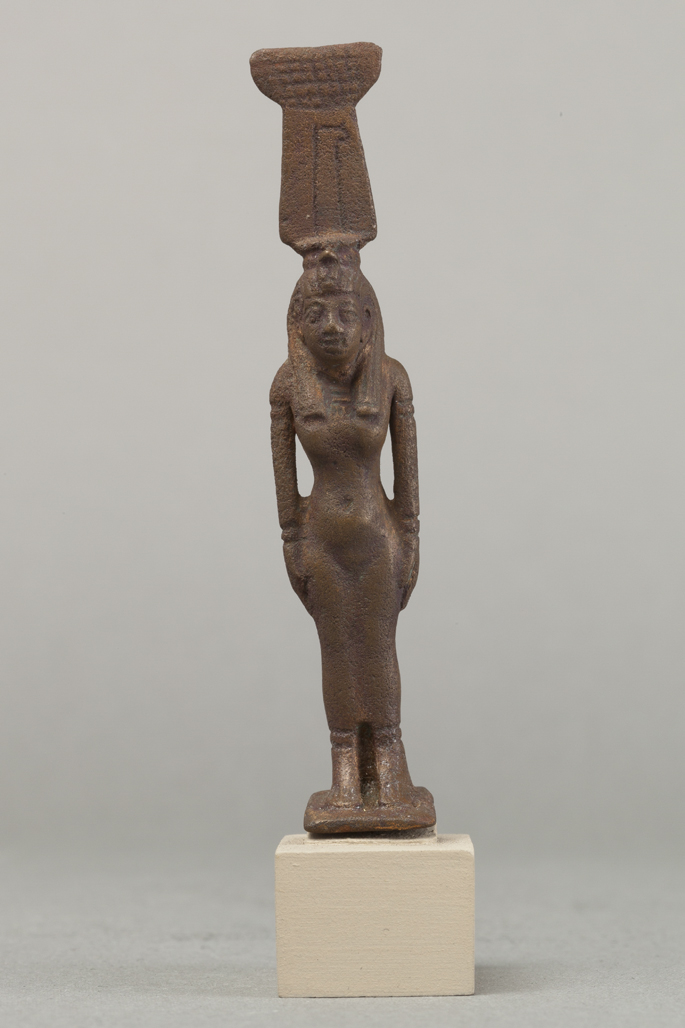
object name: statuette, nephthys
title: Statuette of Nephthys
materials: metal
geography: egypt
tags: goddess